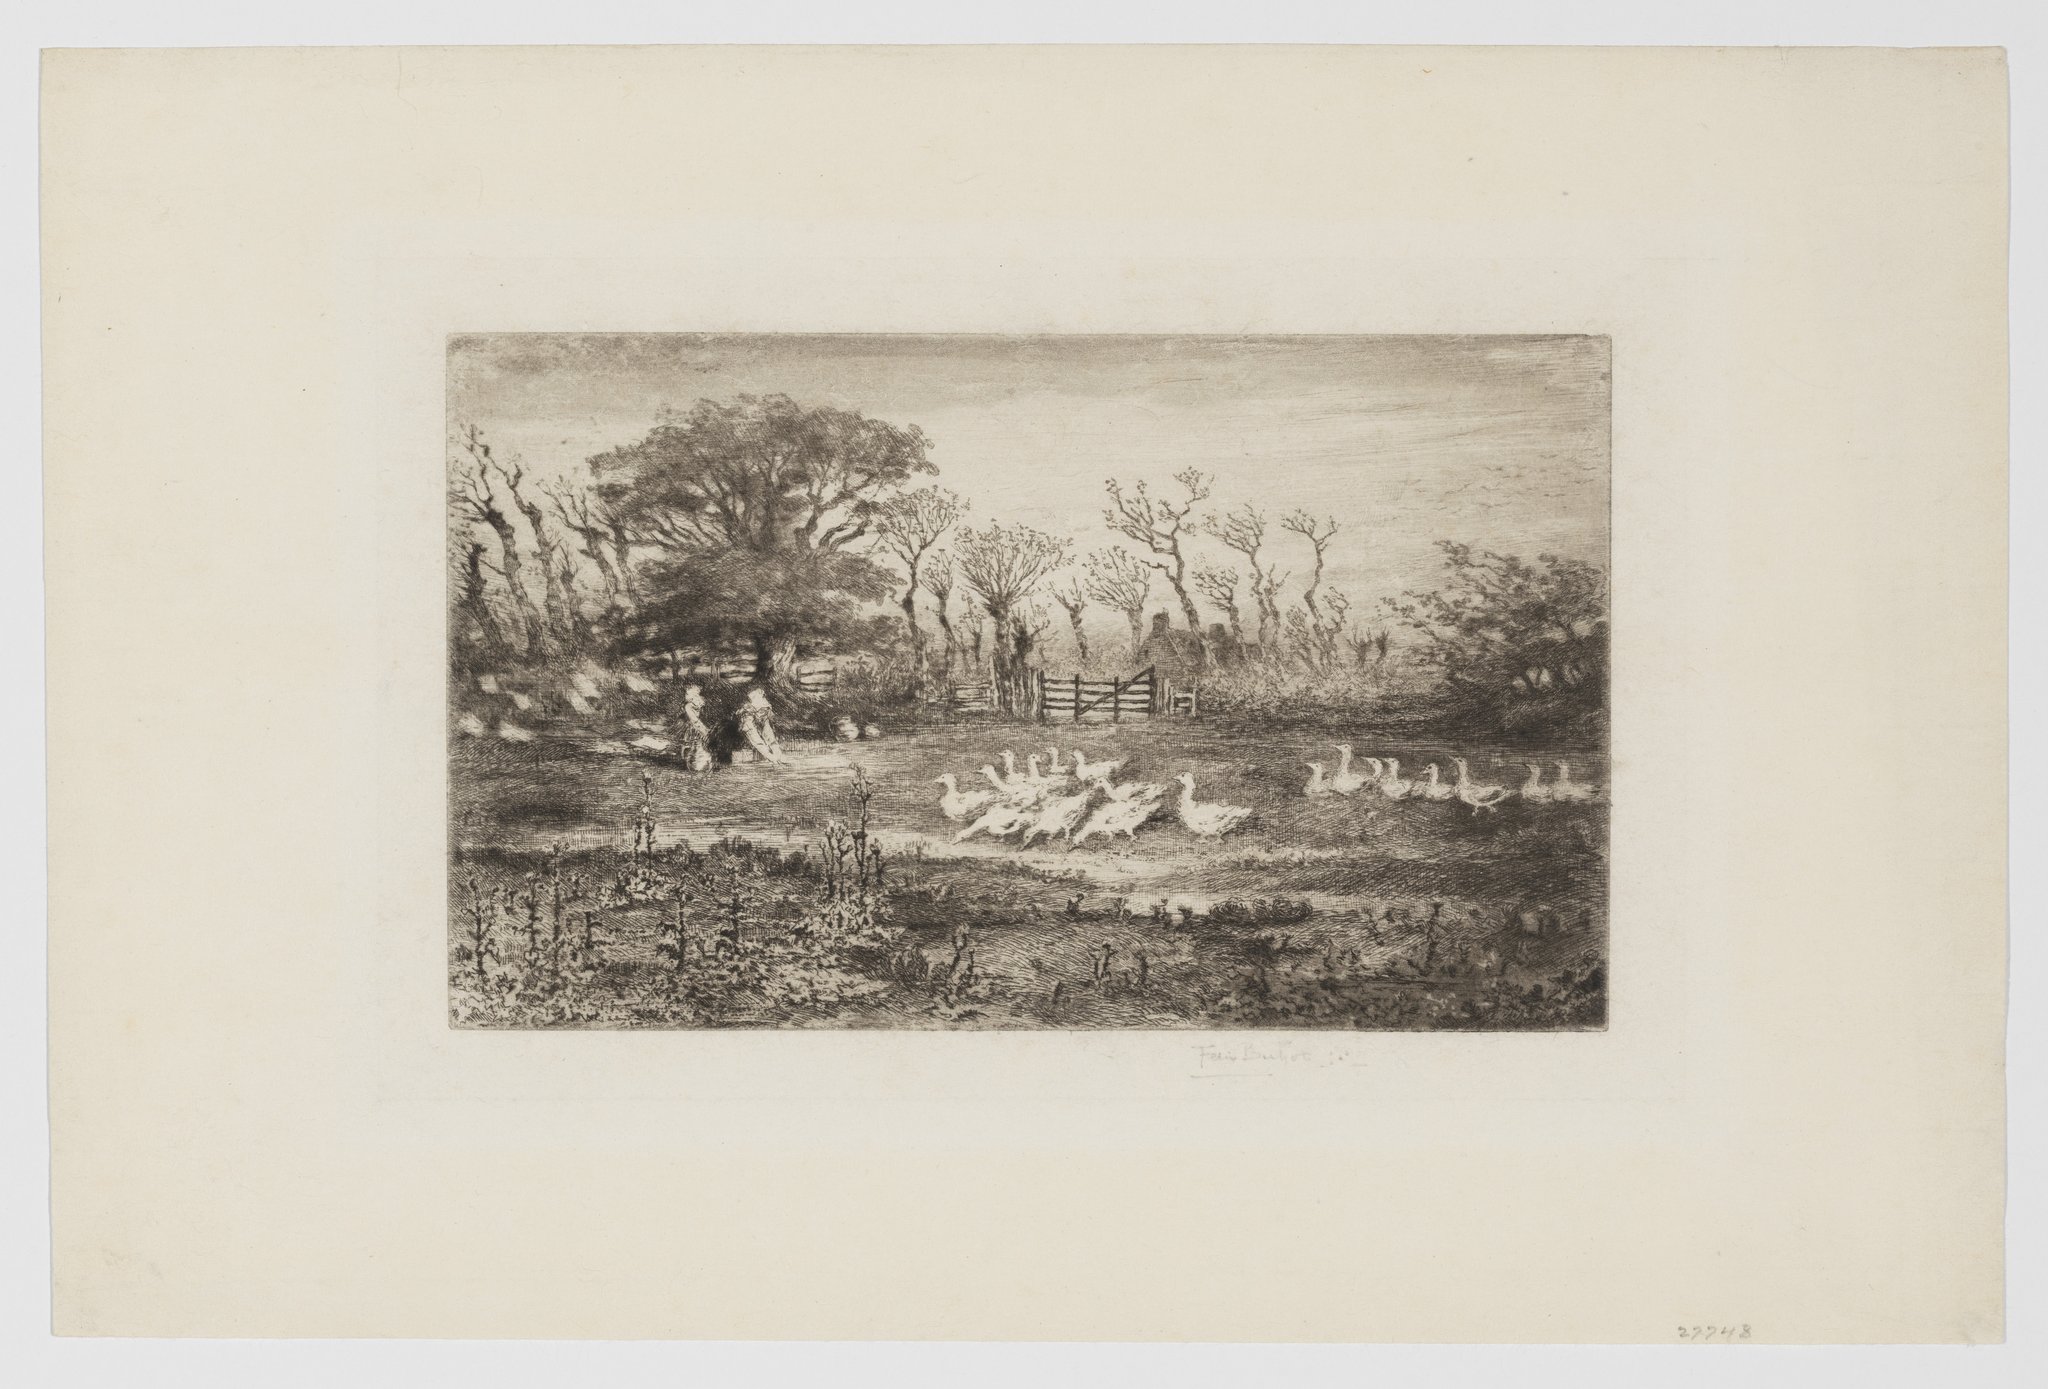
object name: print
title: Les Oies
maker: félix-hilaire buhot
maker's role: artist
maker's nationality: french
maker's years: 1847-1898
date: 1887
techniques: drypoint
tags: geese